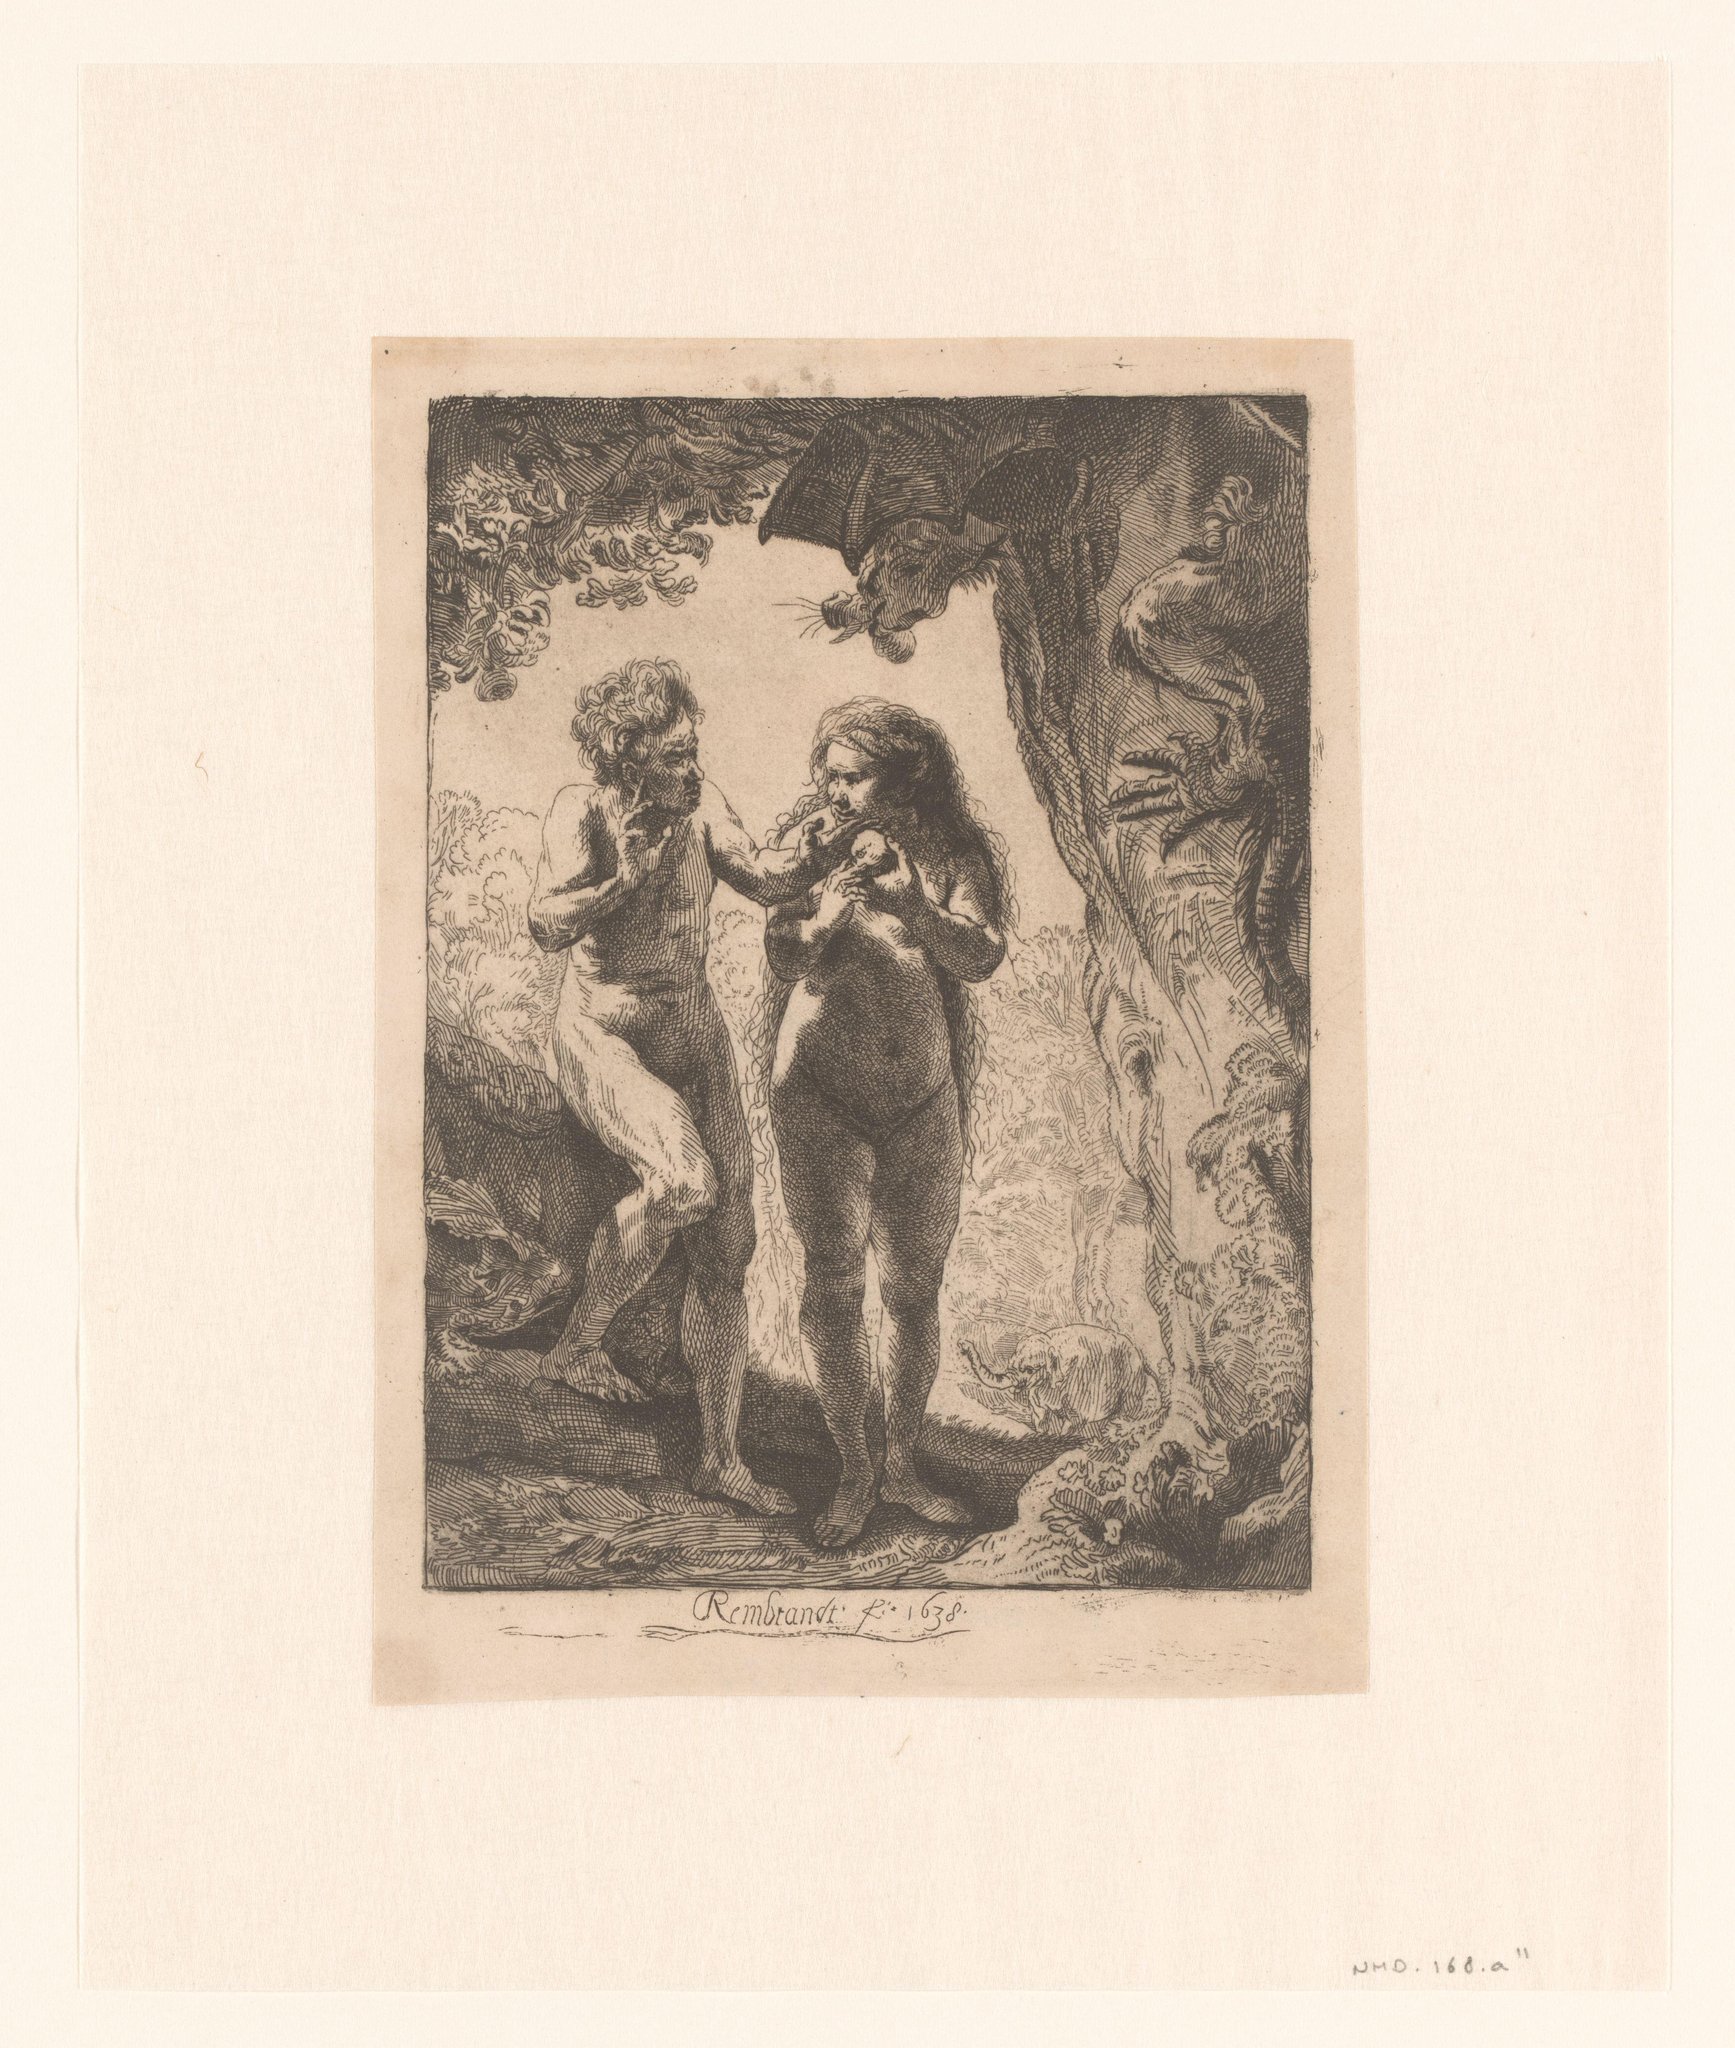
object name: print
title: Adam and Eve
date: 1733-1797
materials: paper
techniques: etching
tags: temptation and fall (genesis 3:1-7)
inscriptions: collector's mark: Lugt 2760, collector's mark: Lugt 2228